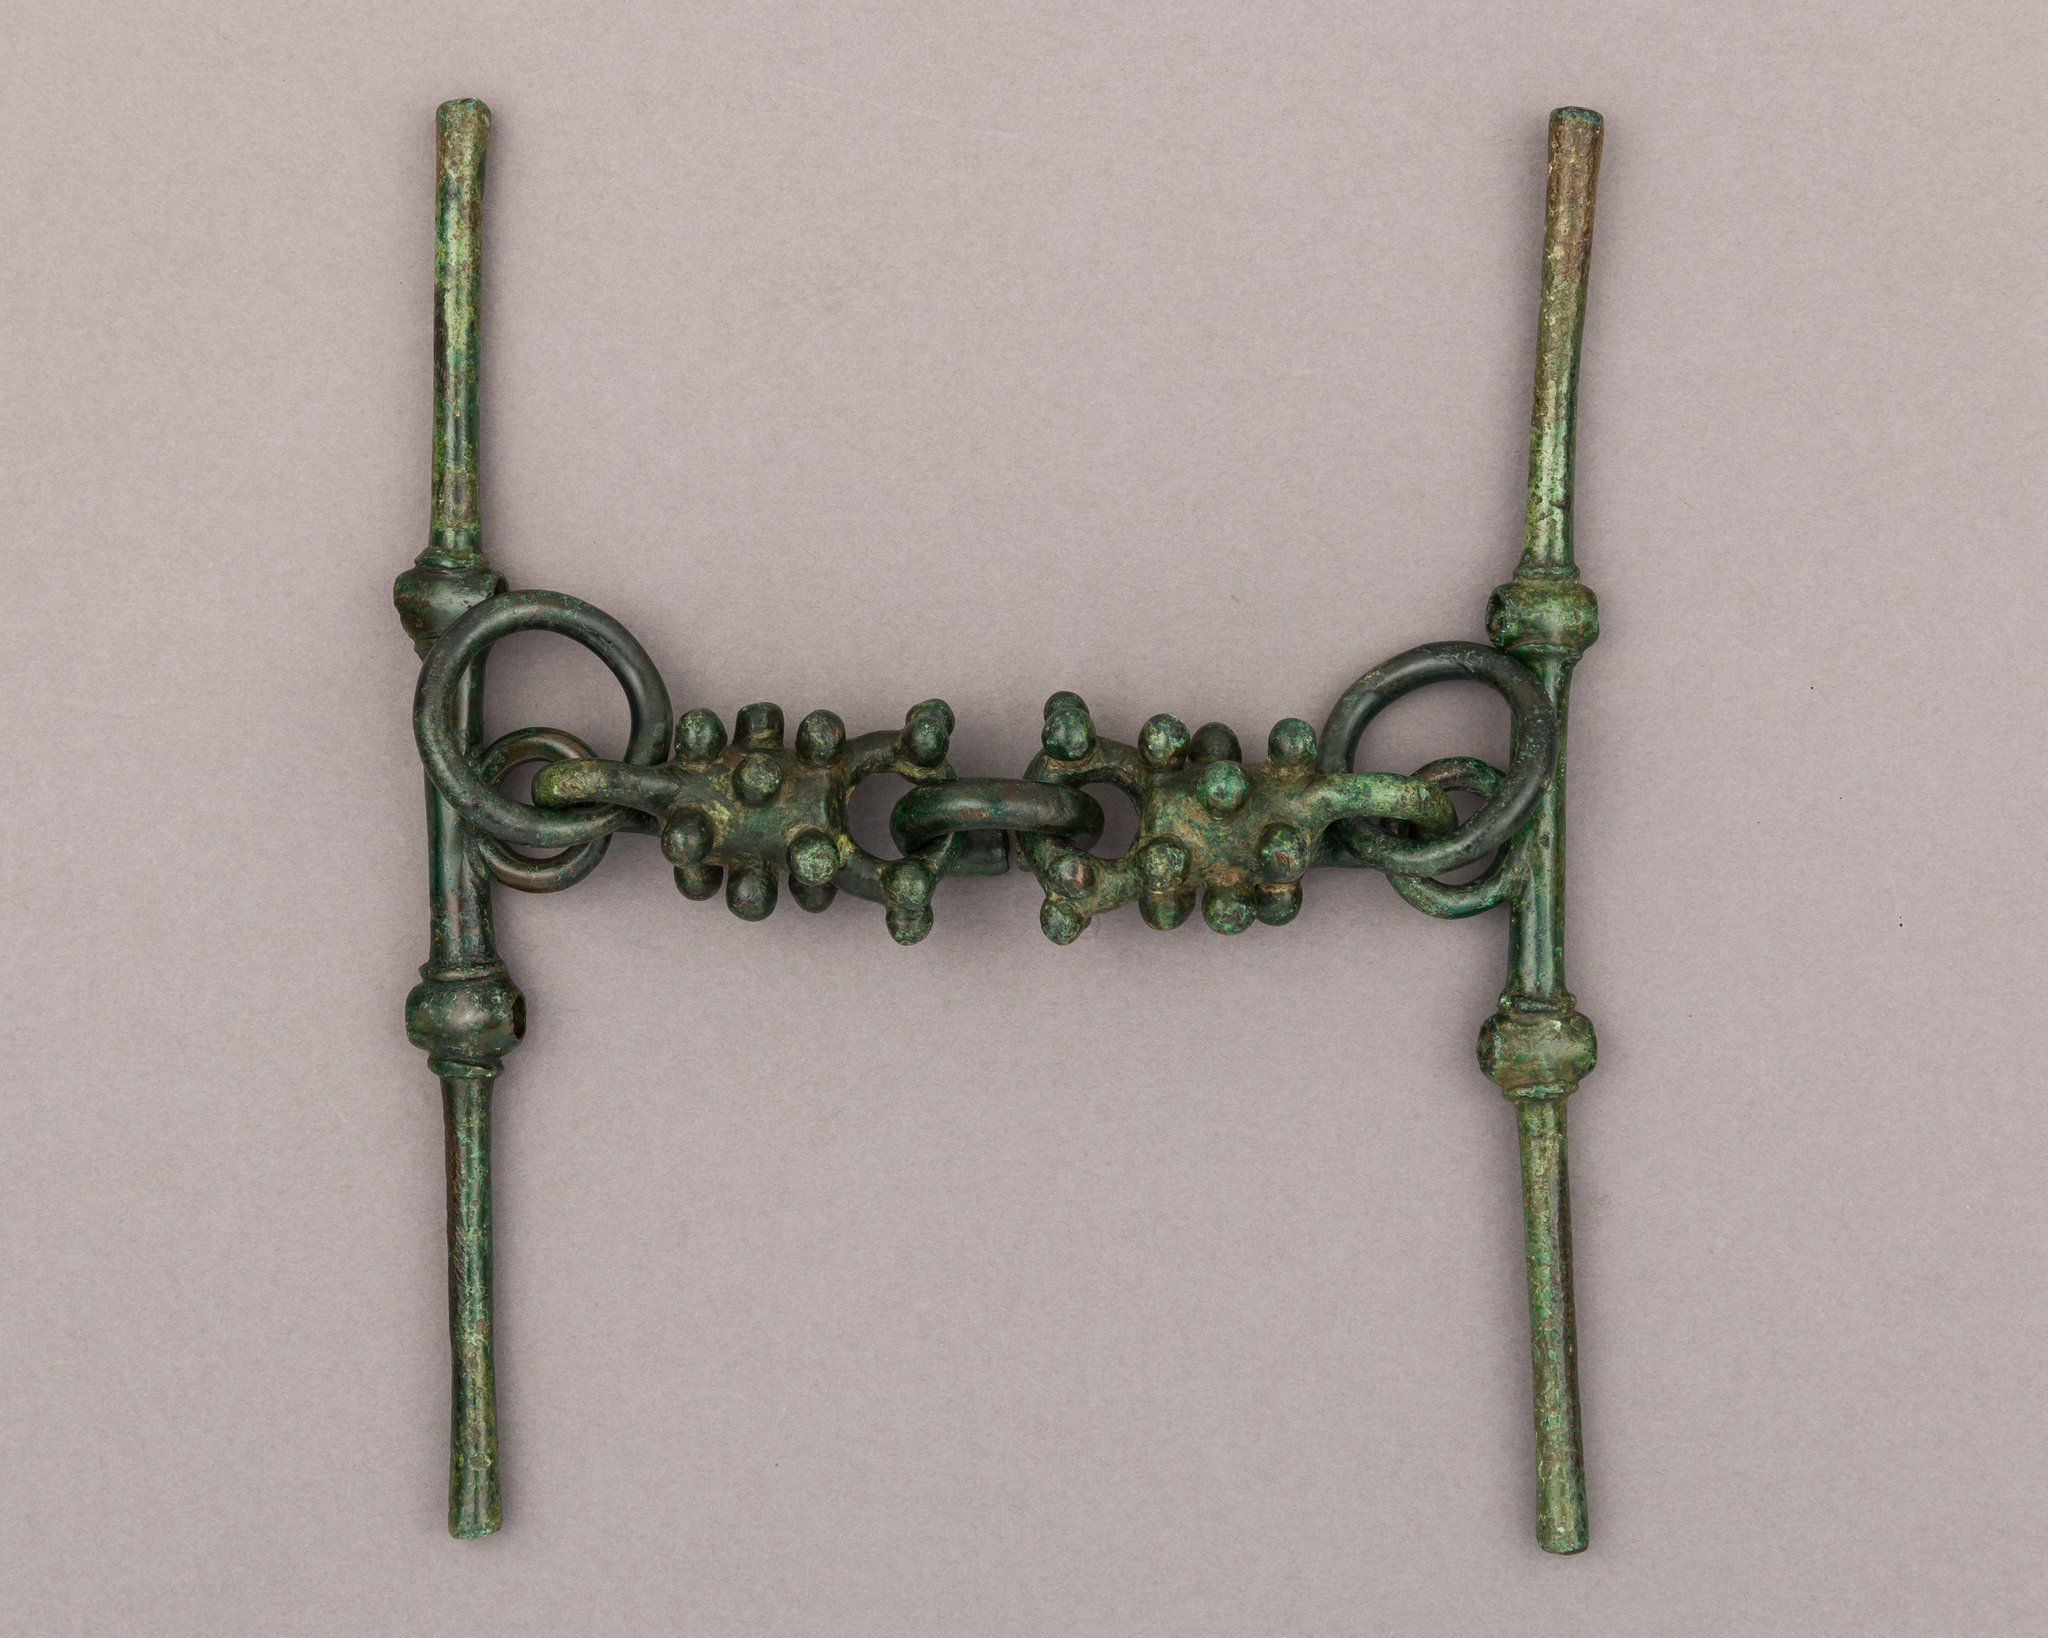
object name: bit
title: Snaffle Bit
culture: anatolian or thracian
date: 300-201 BCE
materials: copper alloy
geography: italy